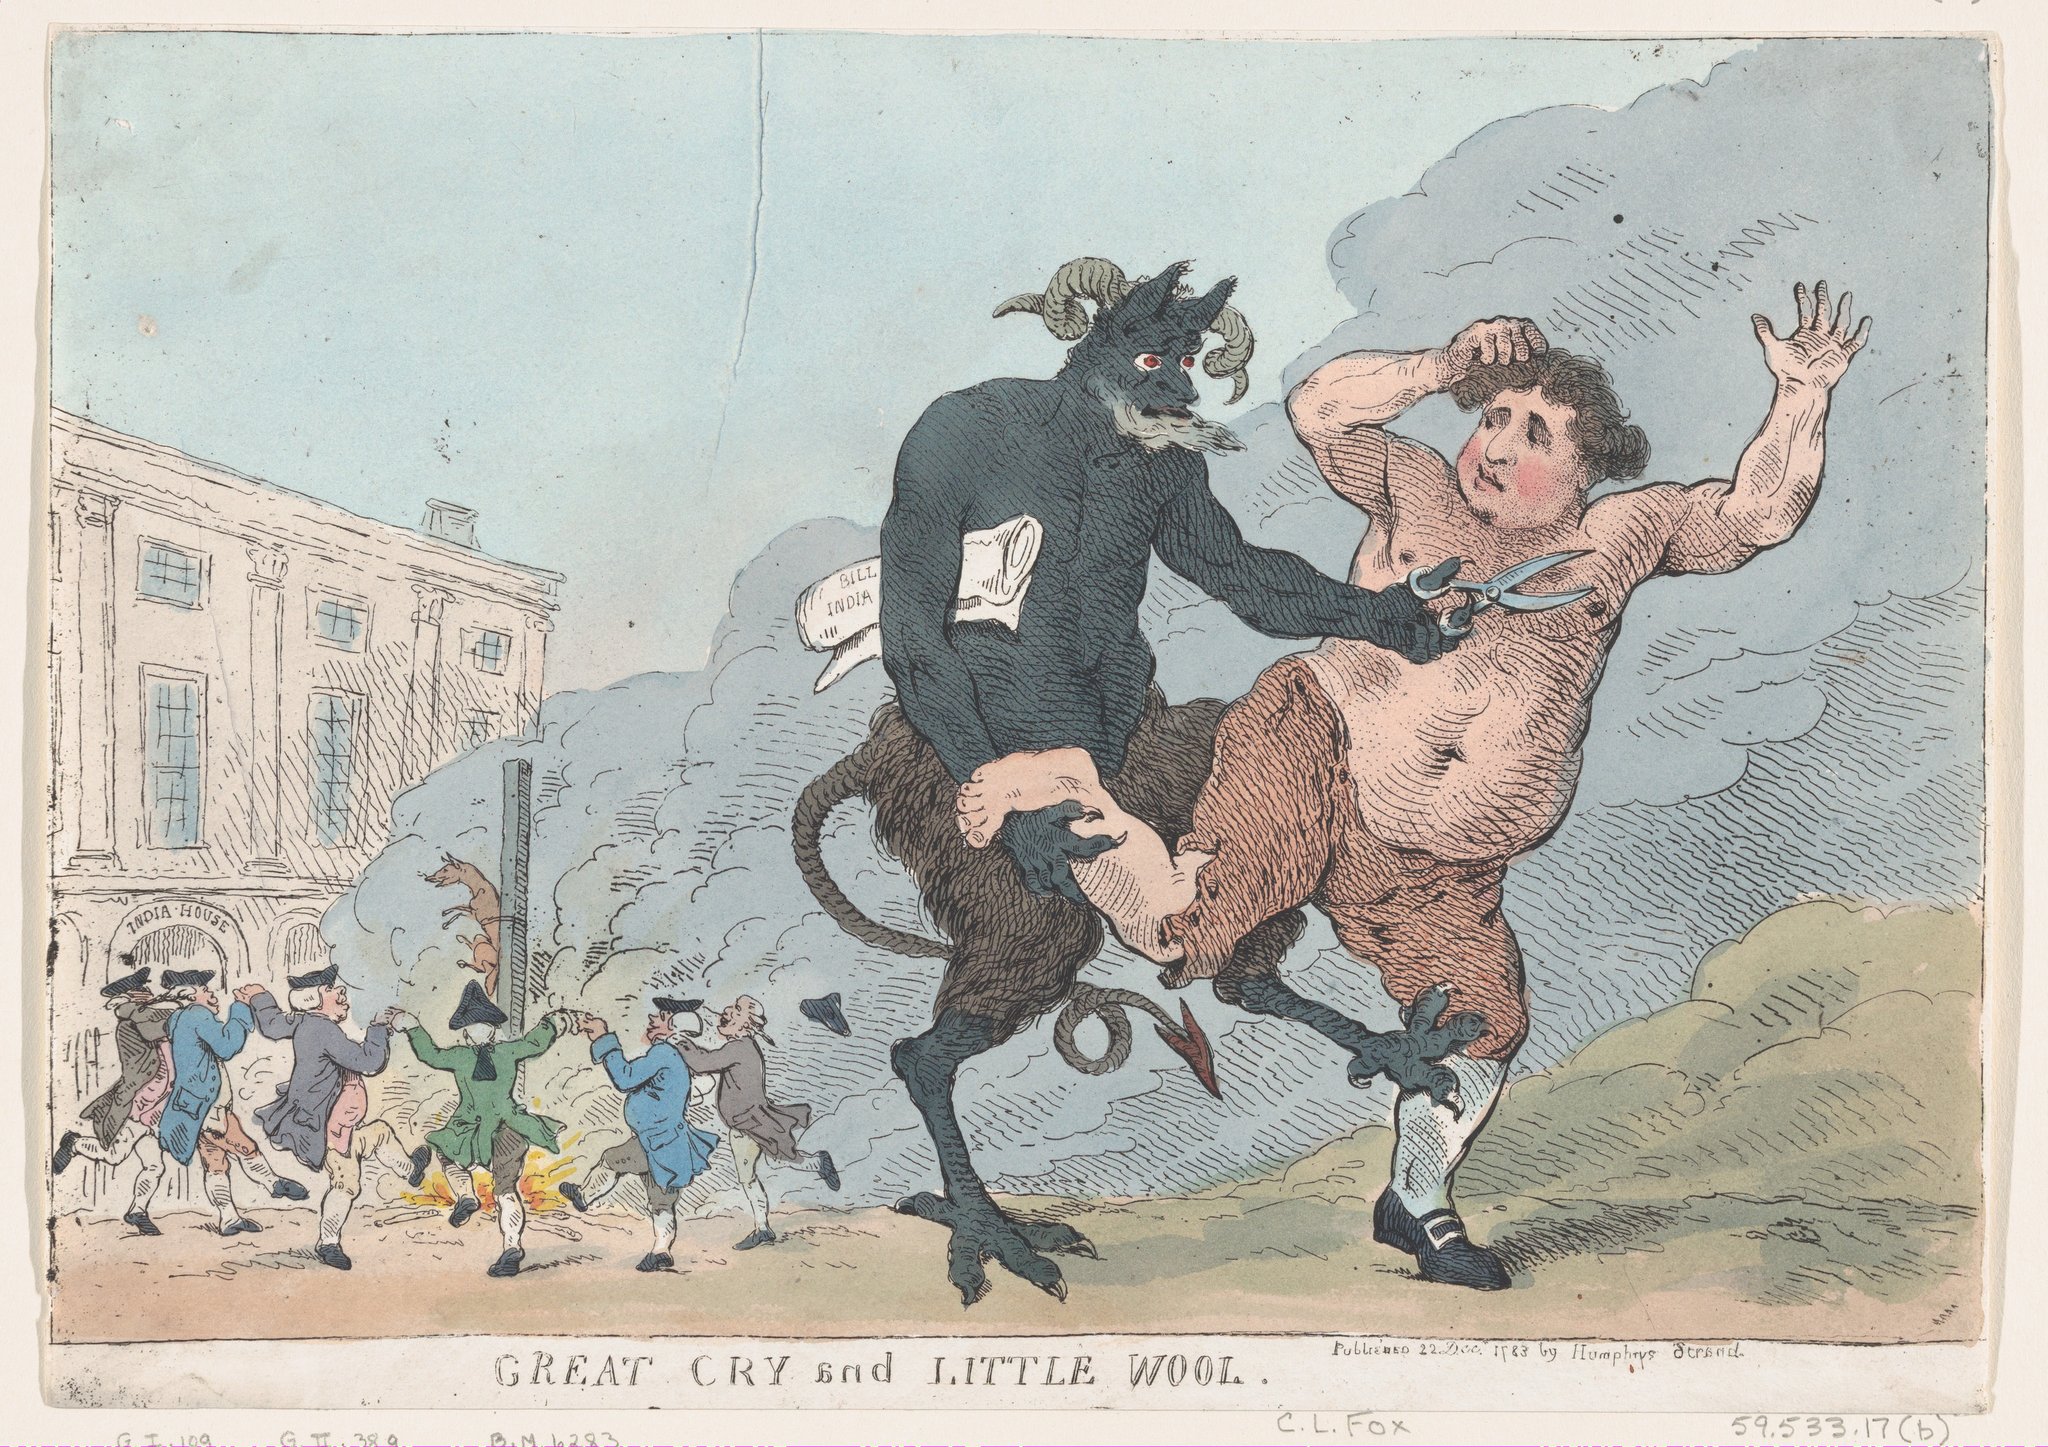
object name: print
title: Great Cry and Little Wool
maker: thomas rowlandson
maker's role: artist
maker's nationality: british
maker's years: 1757-1827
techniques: etching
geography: london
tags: satire,men,devil,politics